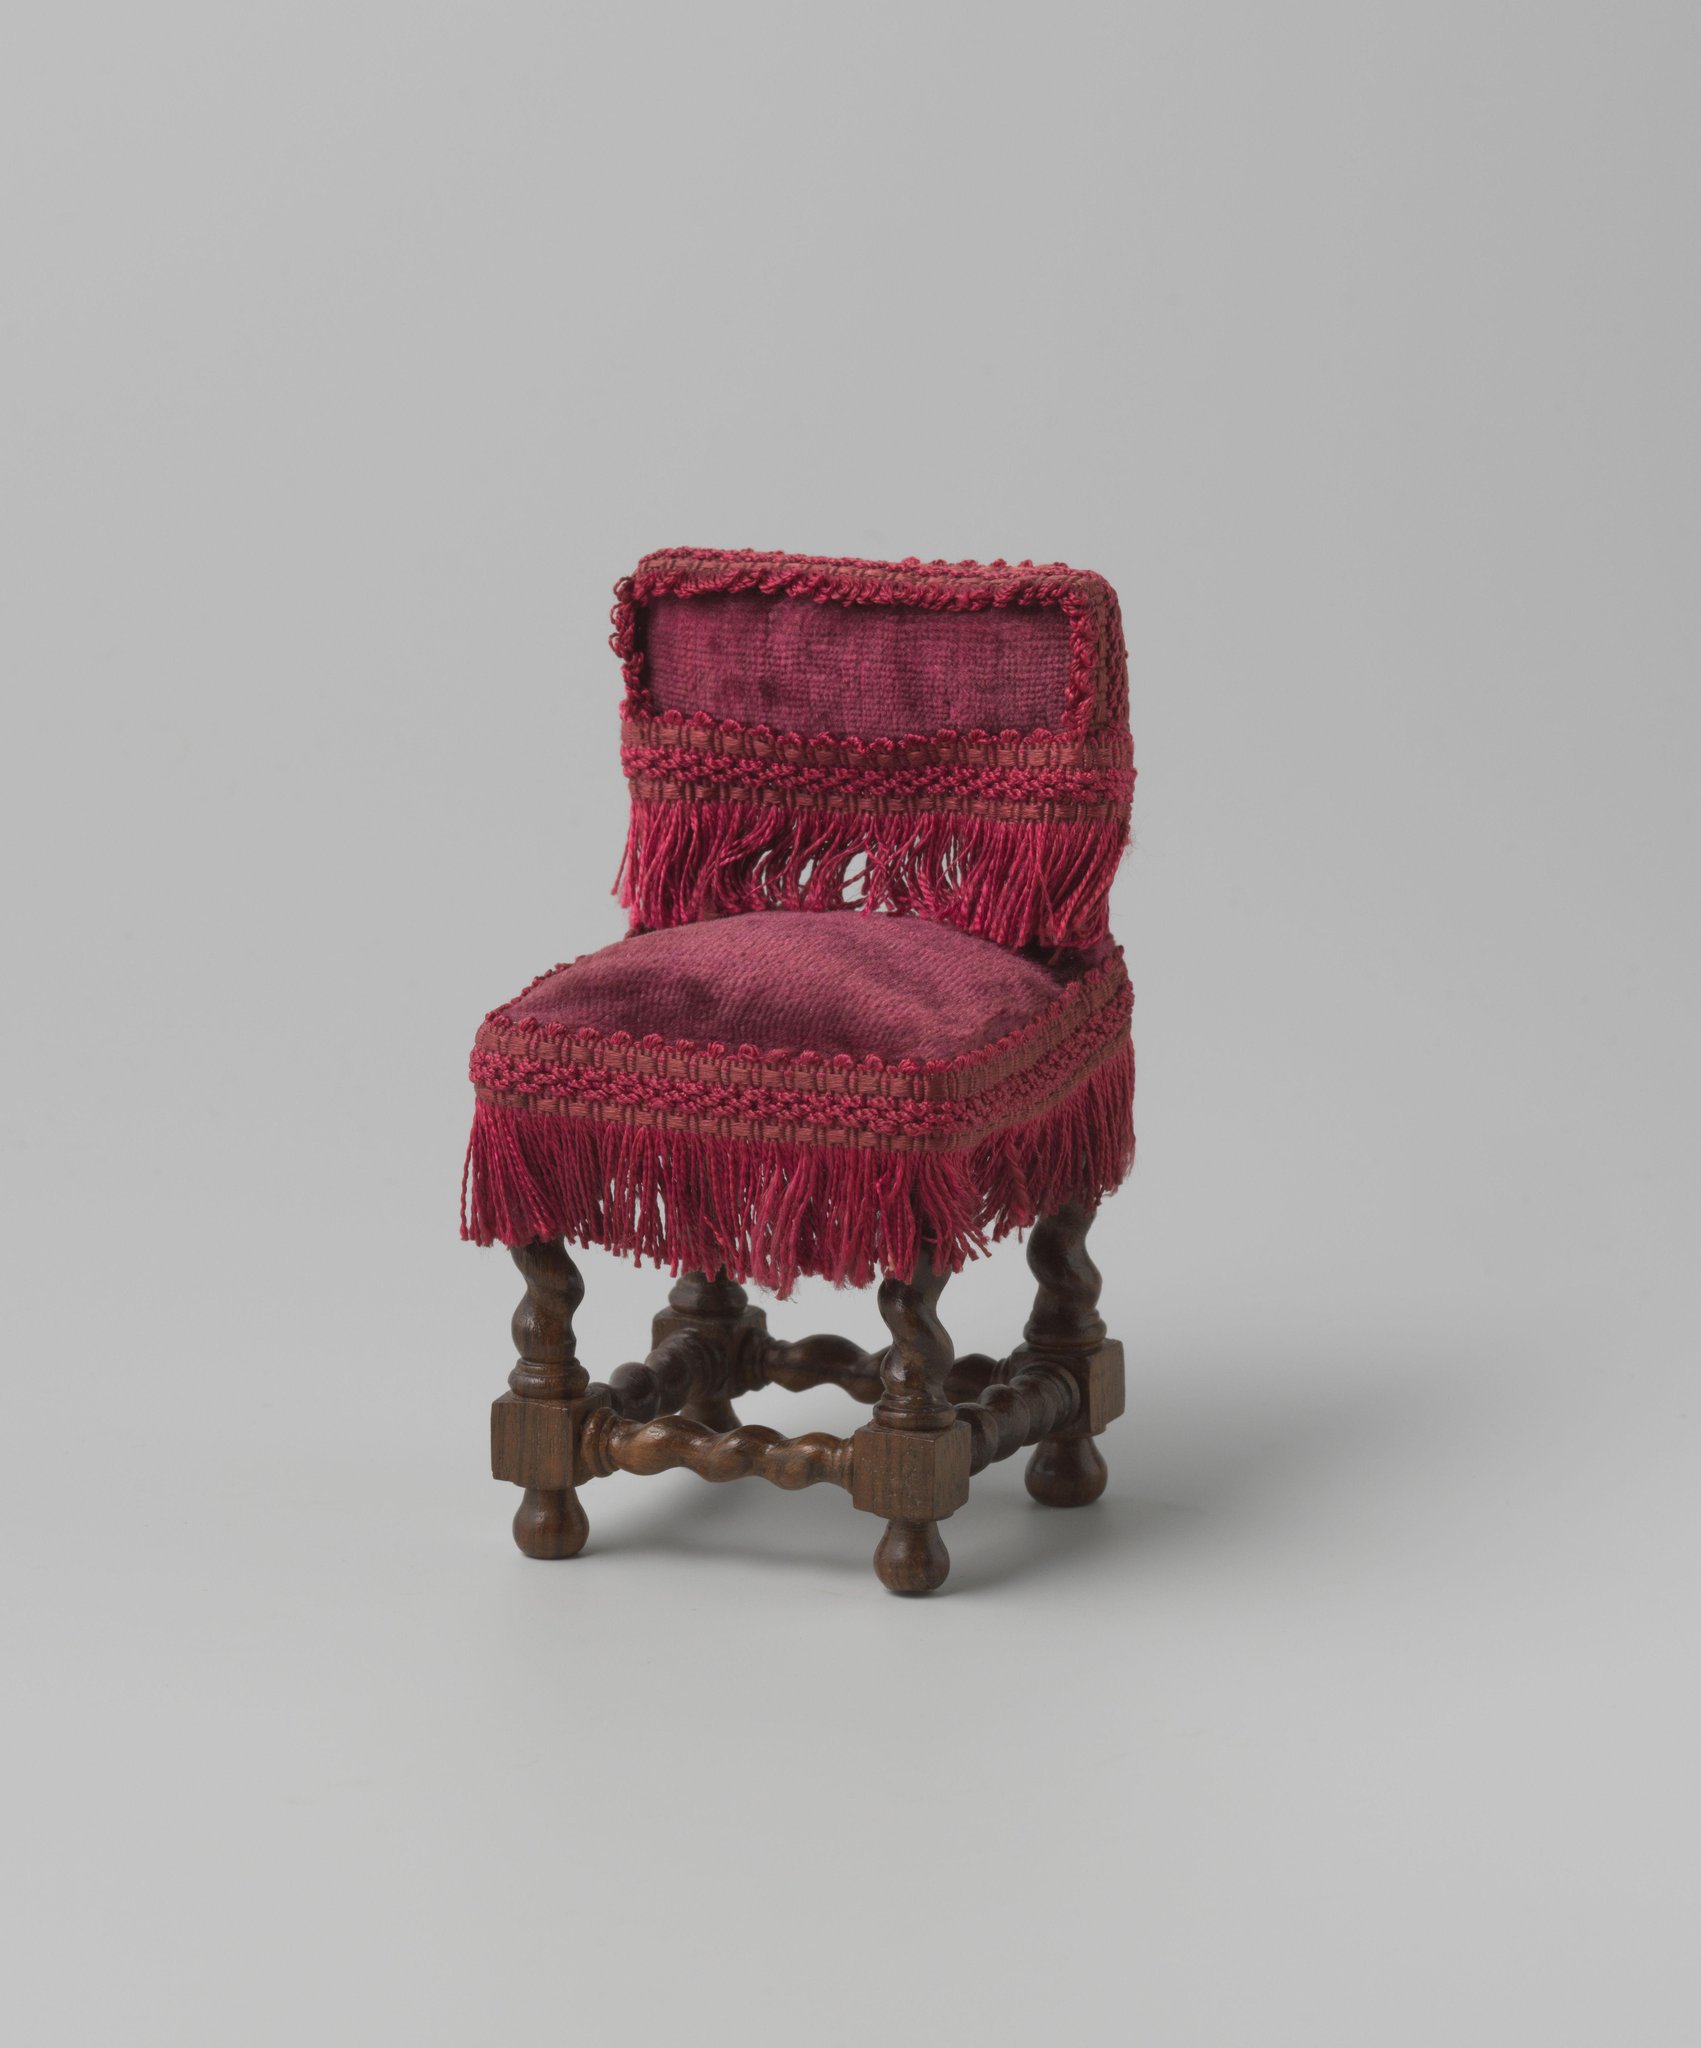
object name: miniature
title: Stoel van notenhout, bekleed met rood fluweel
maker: Anonymous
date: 1676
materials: linen, silk, wood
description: Stoel van notenhout met getorste poten en dwarssporten, met elkaar verbonden in huizen, lage rugleuning, vervaardigd uit een stuk notenhout. De zitting en rug bekleed met bordeaurode zijdefluweel, afgezet met smal, zijden passement met lussen en breder passement met losse franje. Zitting gevuld op linnen onderlaag. Achterstijl tussen zitting en rug eveneens bekleed met fluweel.